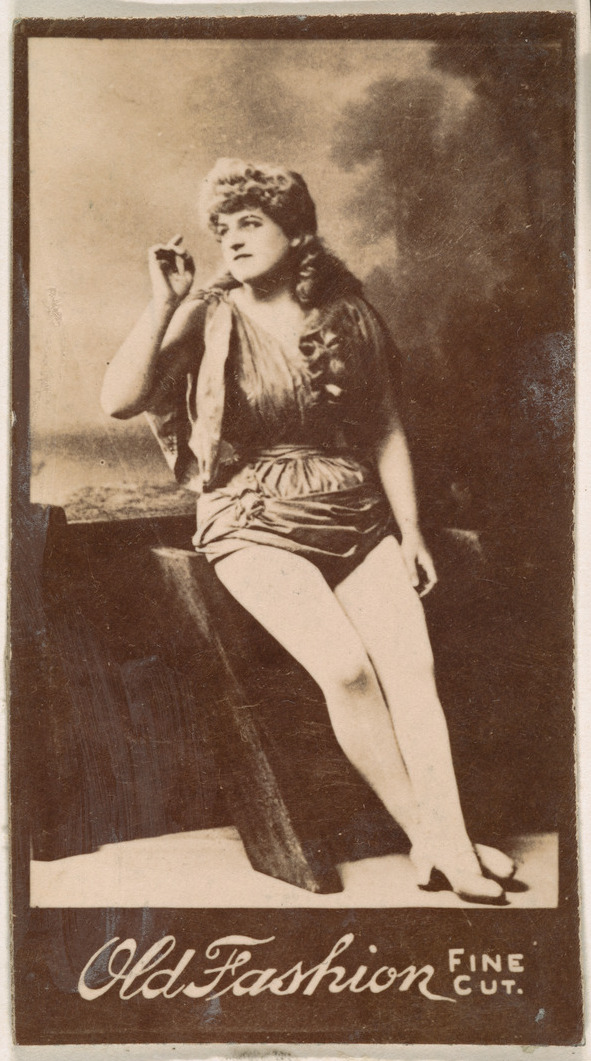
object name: photograph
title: Actress holding arm aloft, from the Actresses series (N664) promoting Old Fashion Fine Cut Tobacco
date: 1888-1890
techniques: albumen silver print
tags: portraits,women,actresses